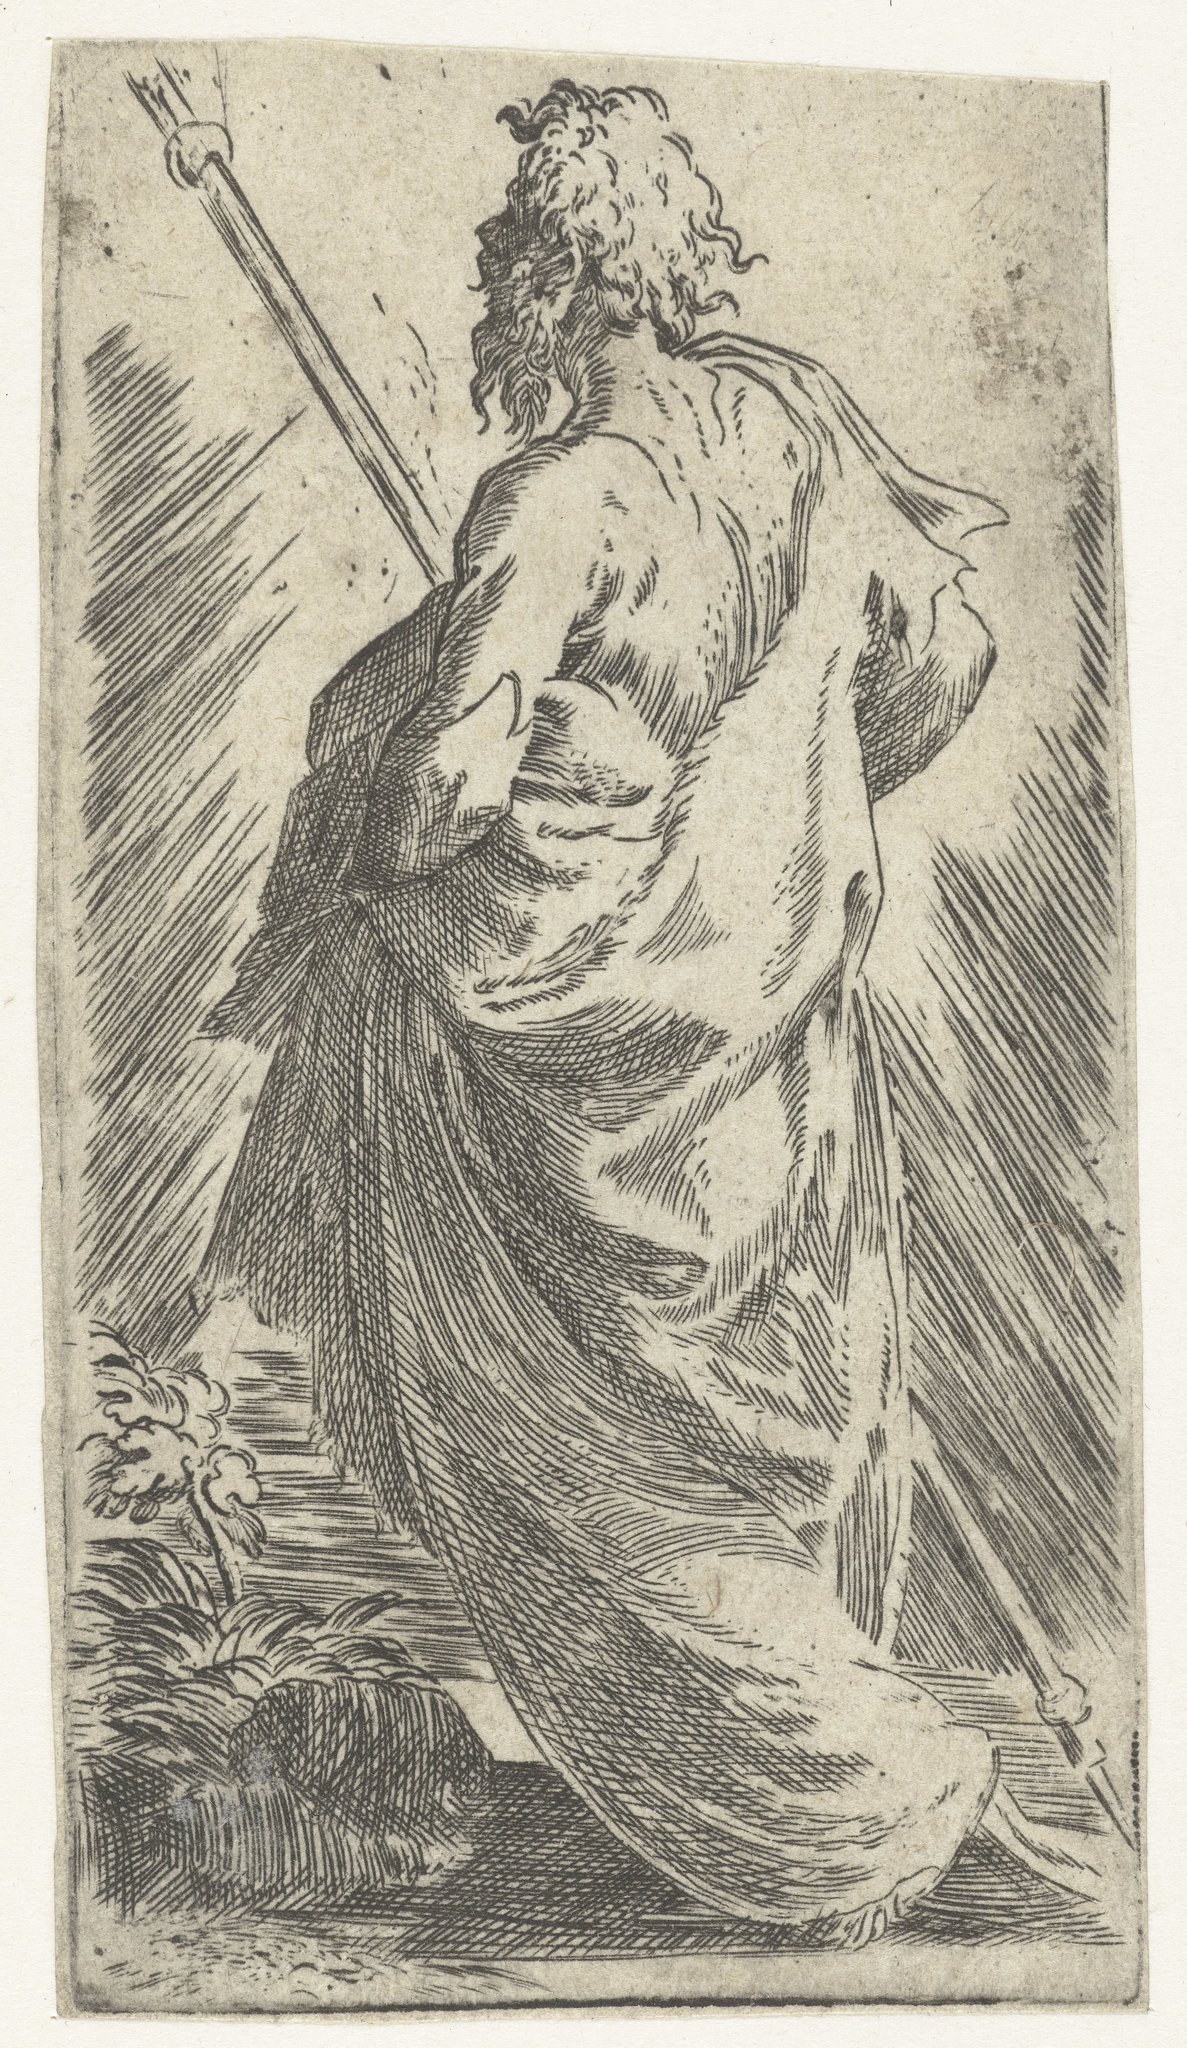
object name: print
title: Apostel Jakobus de Meerdere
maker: parmigianino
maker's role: draughtsman, painter, print maker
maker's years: 1503-1540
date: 1524-1540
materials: paper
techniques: drypoint, engraving, etching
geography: rome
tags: the apostle james the great; possible attributes: book, pilgrim's cloak, hat, shell, staff, and wallet, scroll, sword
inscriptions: collector's mark: Lugt 2228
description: De apostel Jakobus de Meerdere op de rug gezien.